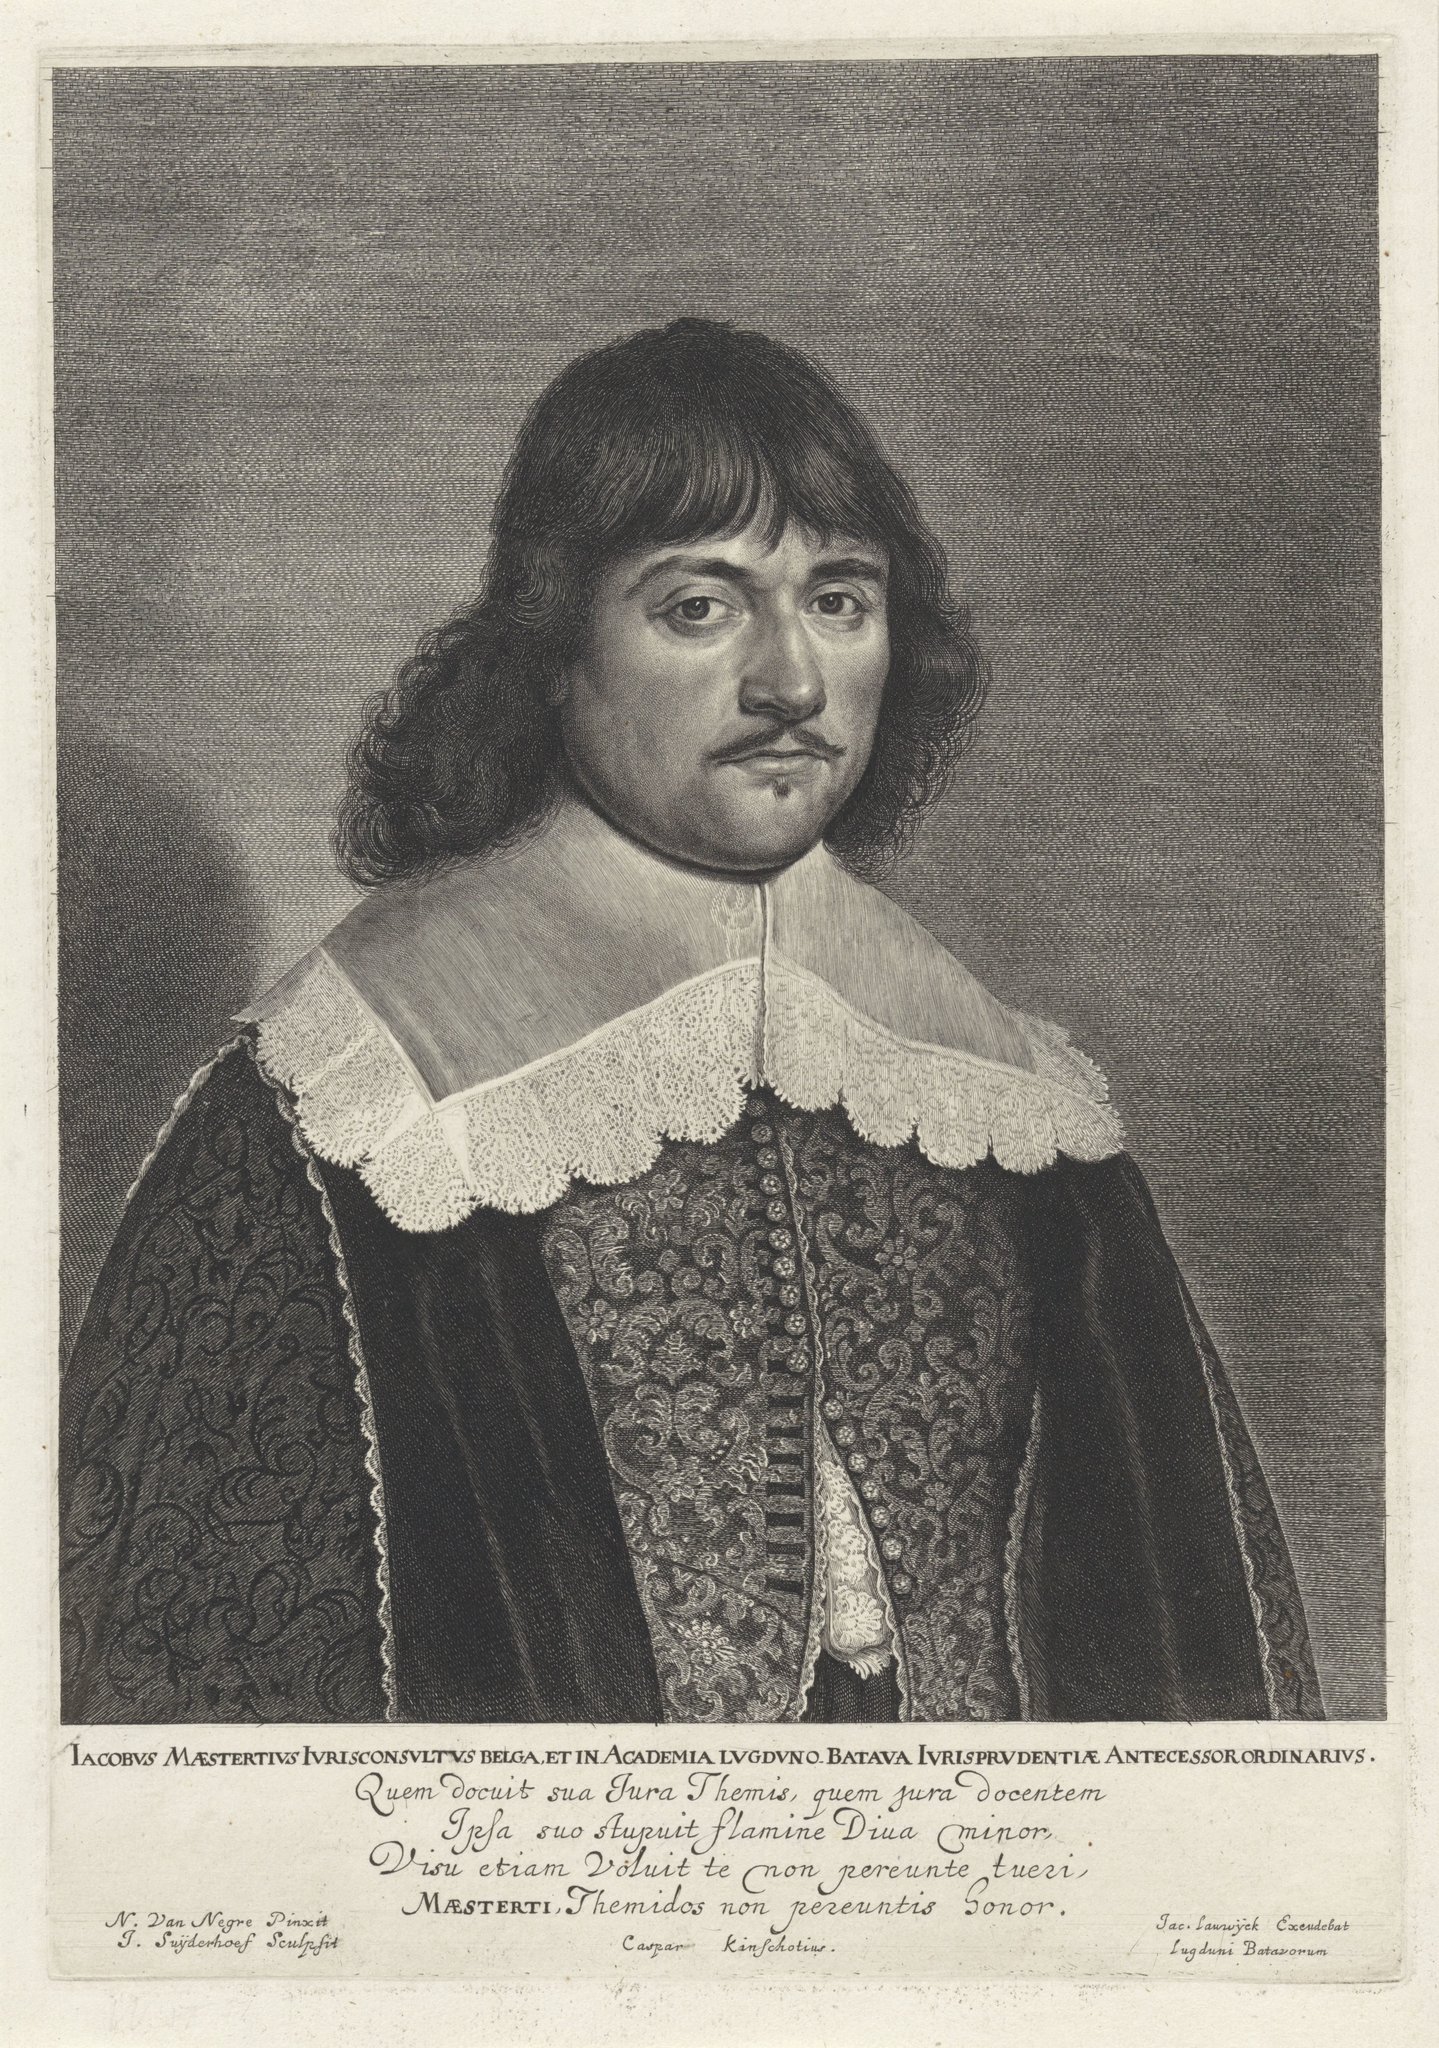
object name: print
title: Portret van Jacob Maestert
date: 1641-1652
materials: paper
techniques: engraving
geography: haarlem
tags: professor (+ portrait of teacher, professor)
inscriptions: collector's mark: Lugt 240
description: Portret van Jacob Maestert, hoogleraar rechten aan de universiteit van Leiden. Onderaan in de marge een vierregelig vers in het Latijn.